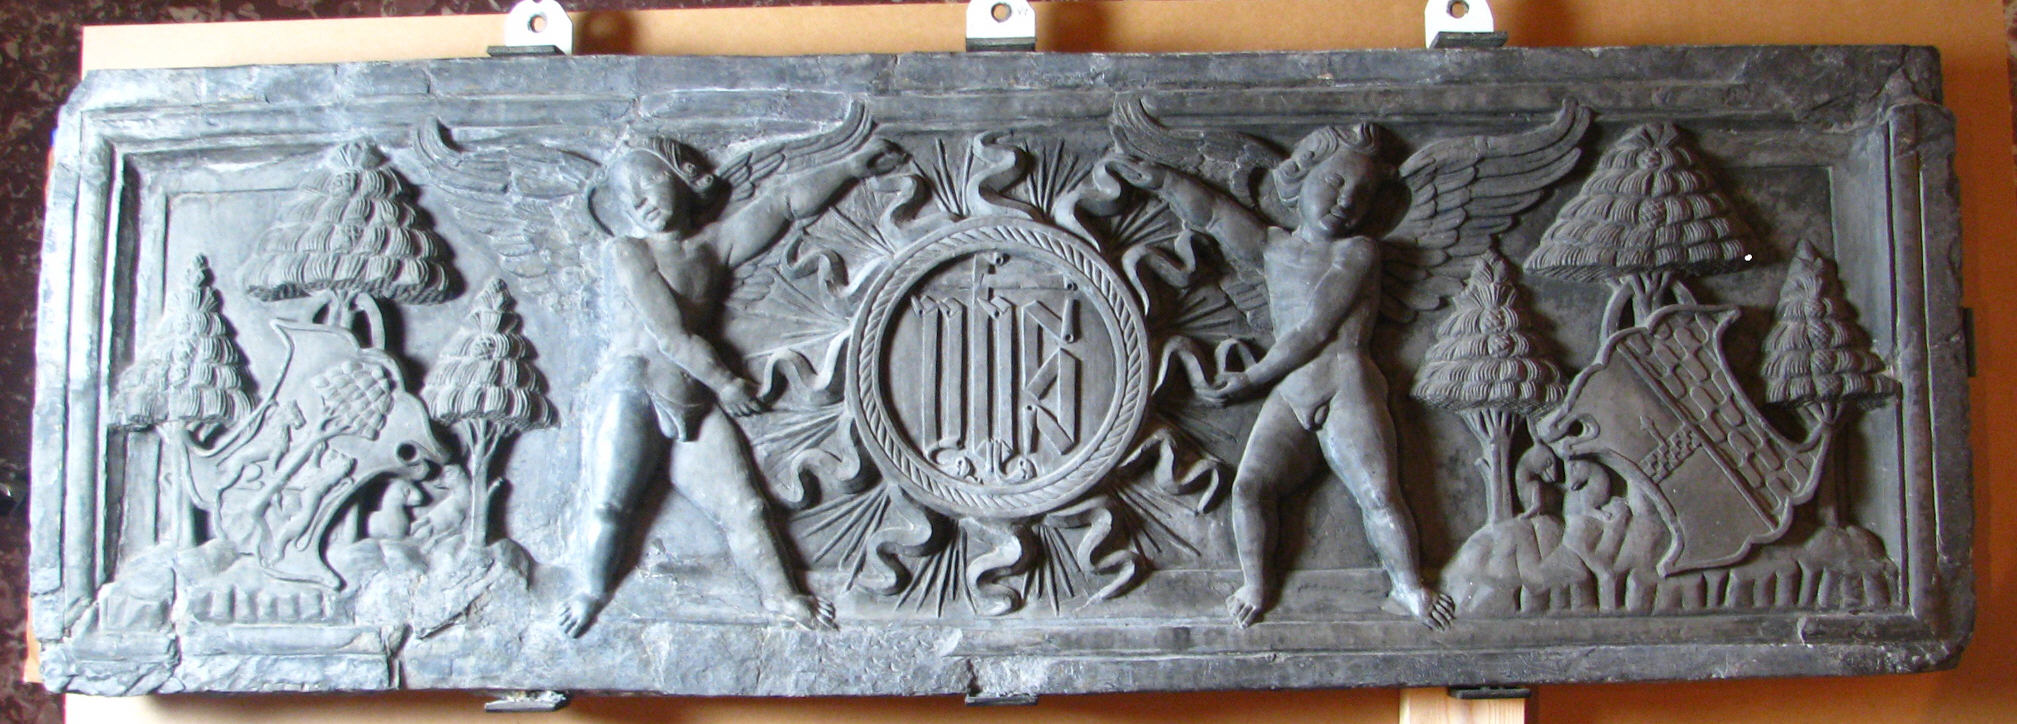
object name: overdoor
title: Angels supporting the arms of Christ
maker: giovanni gagini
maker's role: artist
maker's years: 1449-1517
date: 1500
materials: stone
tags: animals,trees,angels,insignia